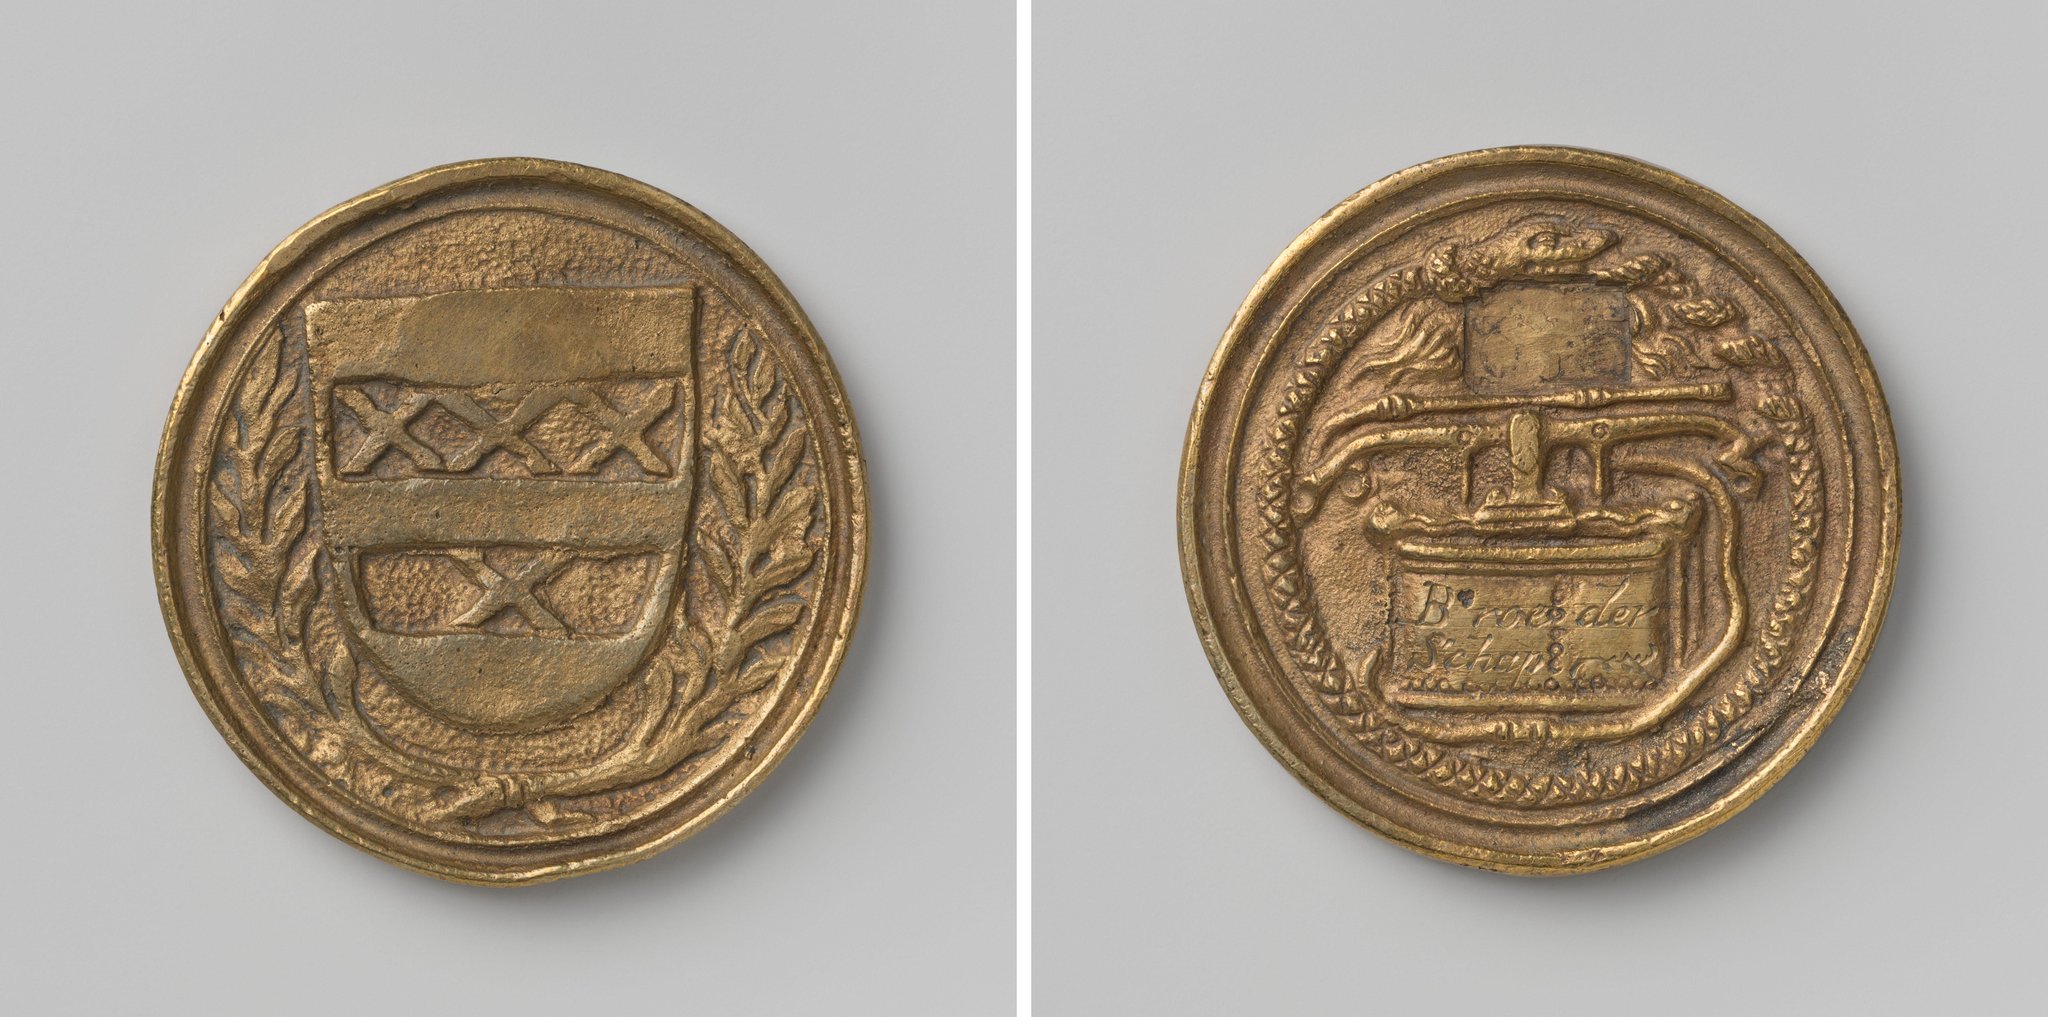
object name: fire engine medal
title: Nieuwer Amstel, brandspuitpenning met opschrift Broederschap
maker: Anonymous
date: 1680-1800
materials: brass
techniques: casting, engraving, gilding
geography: amsterdam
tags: nieuwer-amstel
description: Messing penning. Voorzijde: wapenschild binnen bladertakken. Keerzijde: brandspuit onder lege rechthoek binnen slangerond; op zijde van brandspuit: opschrift Broederschap